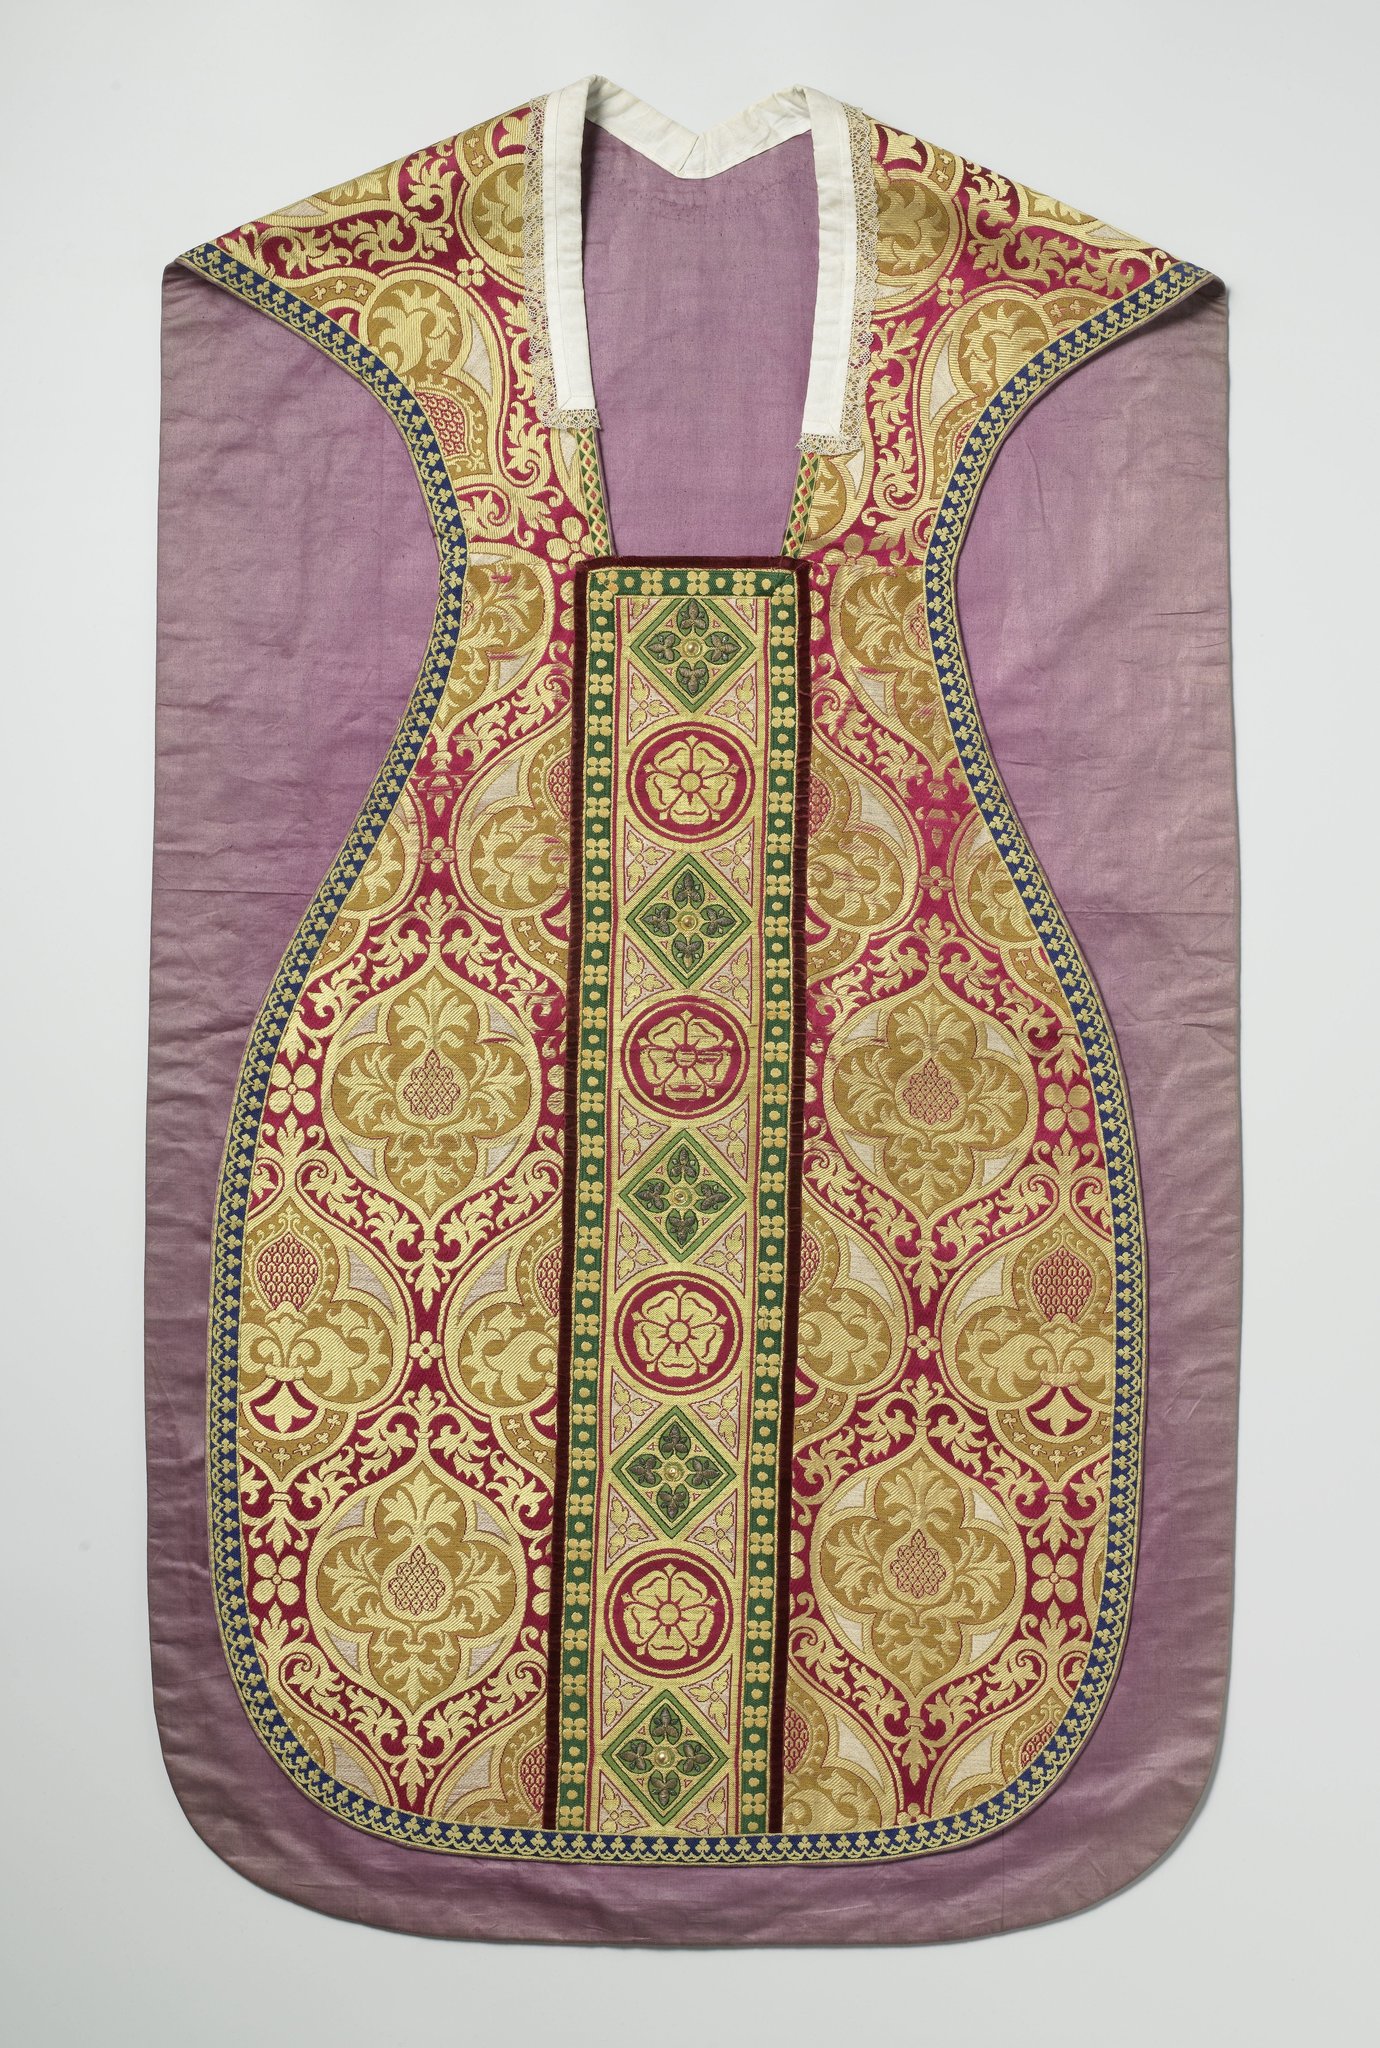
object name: chasuble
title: Kazuifel van zijde met een patroon van vierpassen binnen ovale velden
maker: Anonymous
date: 1850-1900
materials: metal thread, pearl, silk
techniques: embroidered, gilding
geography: roermond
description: Kazuifel van zijde met een patroon van vierpassen binnen ovale velden. Details van de geappliceerde aurifrisia en het rugkruis hebben toegevoegd borduursel van verguld metaaldraad, opgenaaide sierstenen en parels en tonen het Christusmonogram IHS; bovendien geappliceerde voorstellingen van de H. Jozef met het Christuskind en van de H. Ignatius van Loyola. Neo-gotiek.